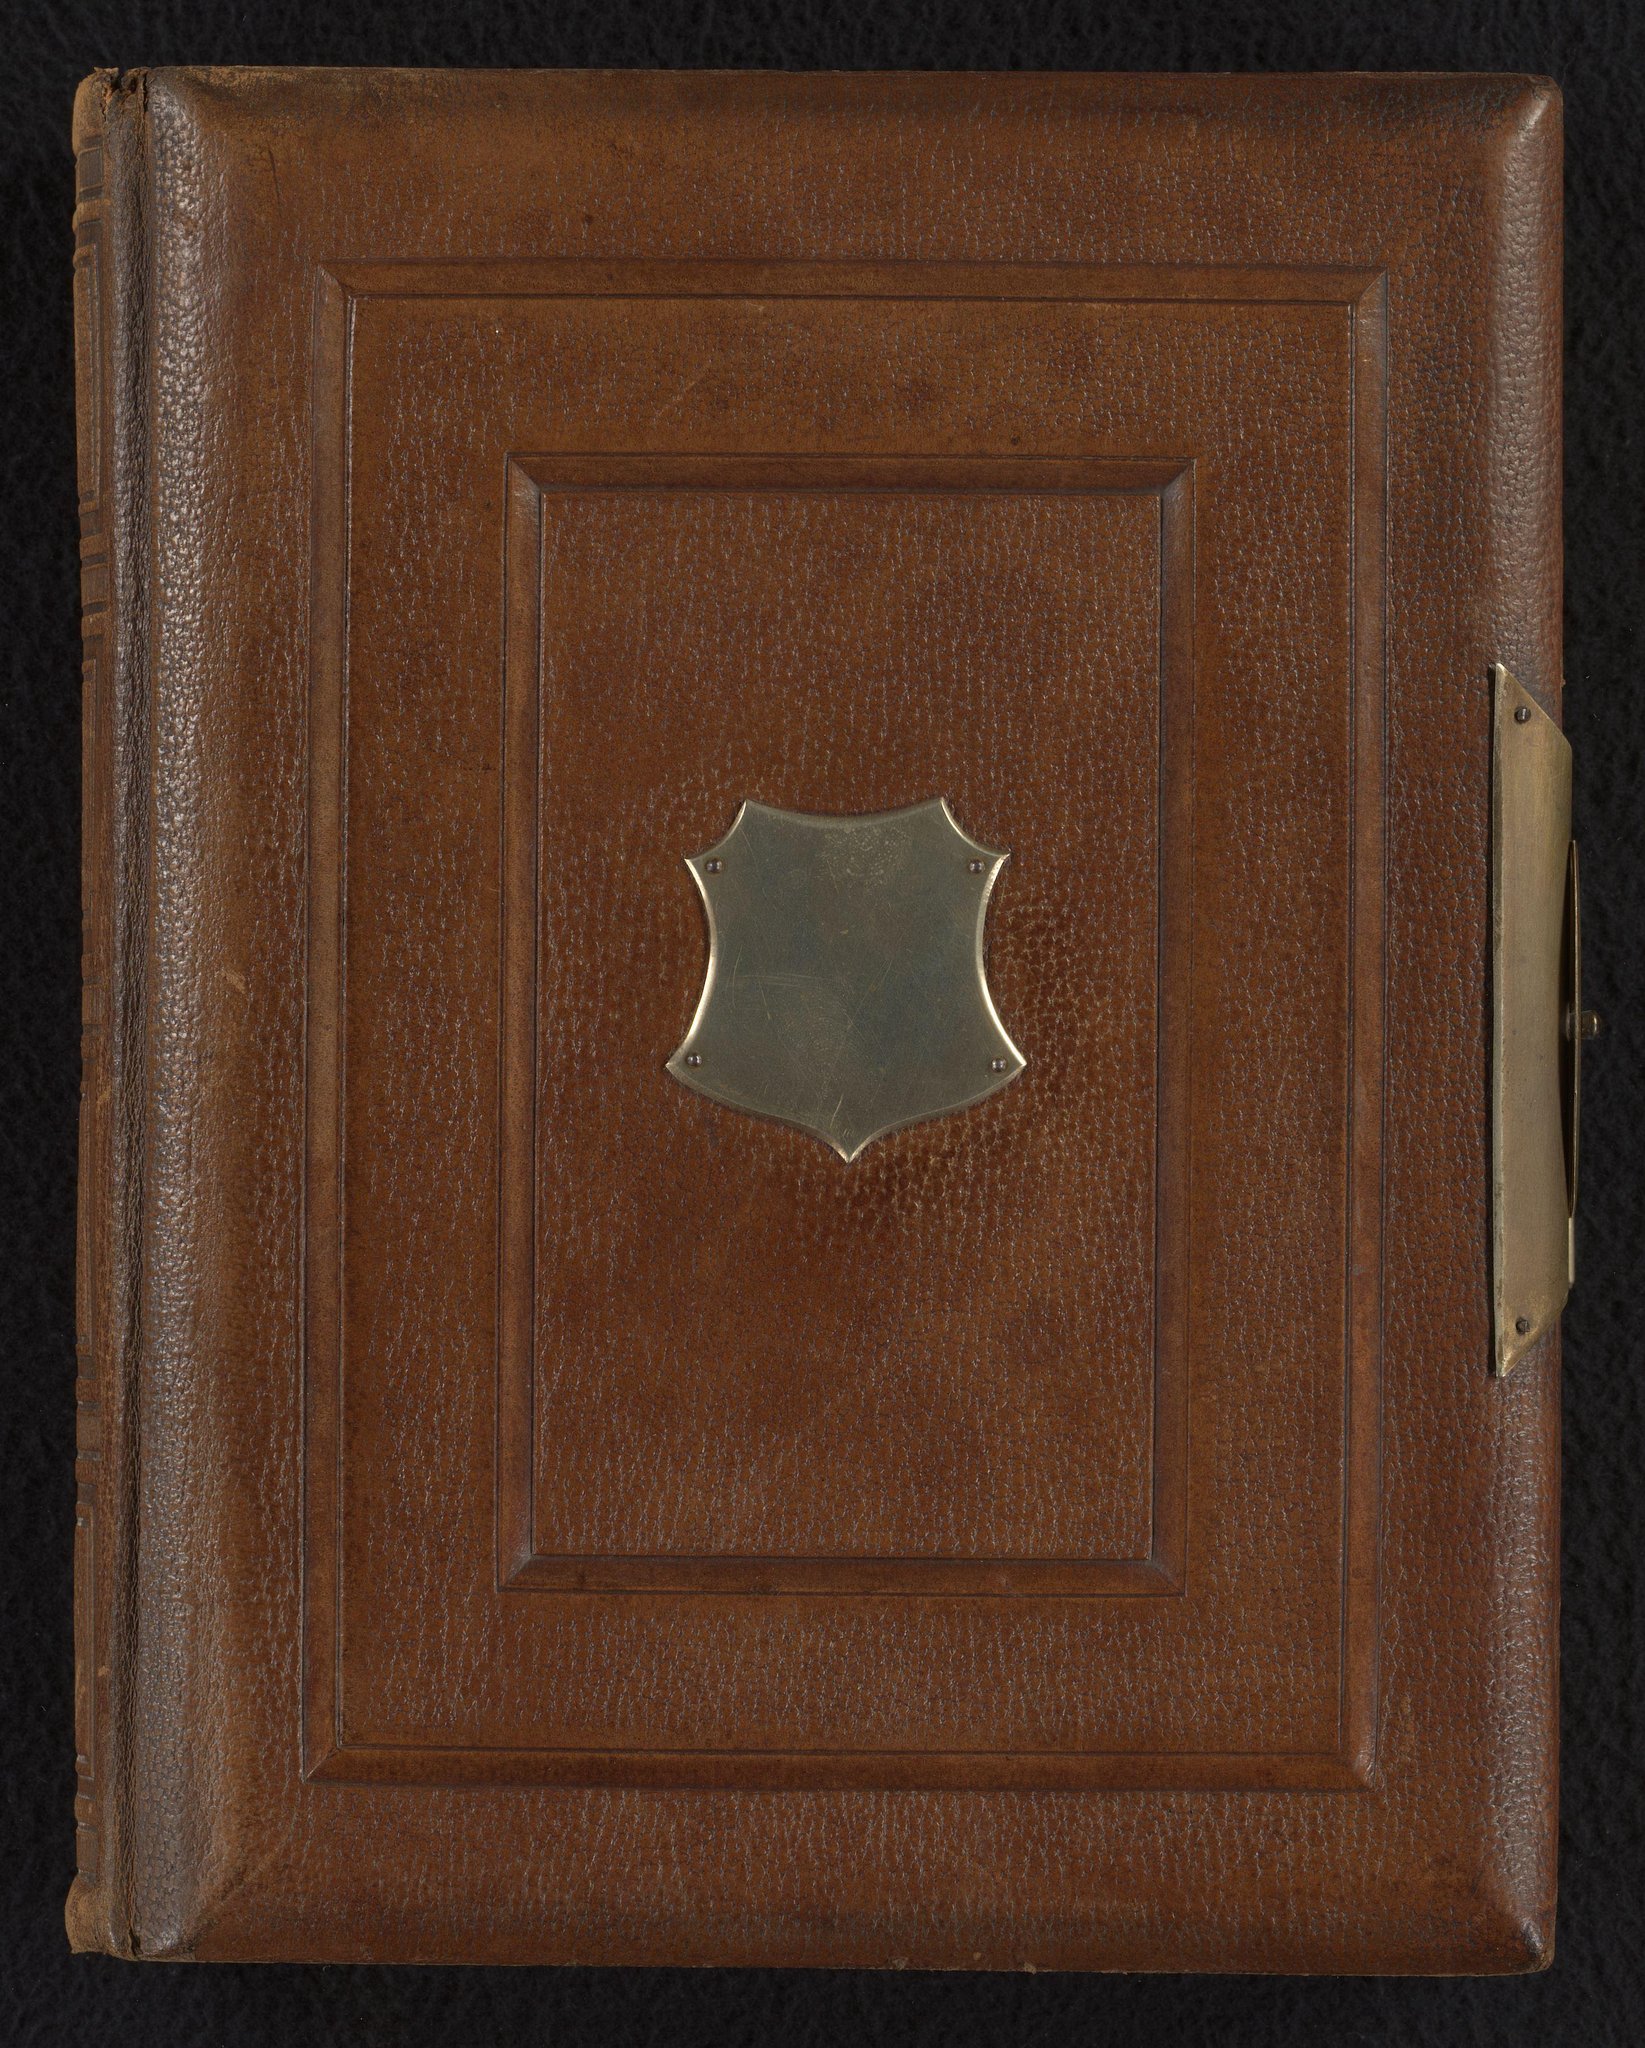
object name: photograph album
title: Fotoalbum (leeg)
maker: Anonymous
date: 1860-1900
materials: cardboard, leather, metal, paper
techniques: color on snow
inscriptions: collector's mark: ‘DIENST/ VERSPREIDE/ RIJKSKOLLEKTIES/ (...) 819’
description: Fotoalbum met 48 pagina's met ieder een met oranje lijnen omkaderde passe-partout voor een kabinetfoto.